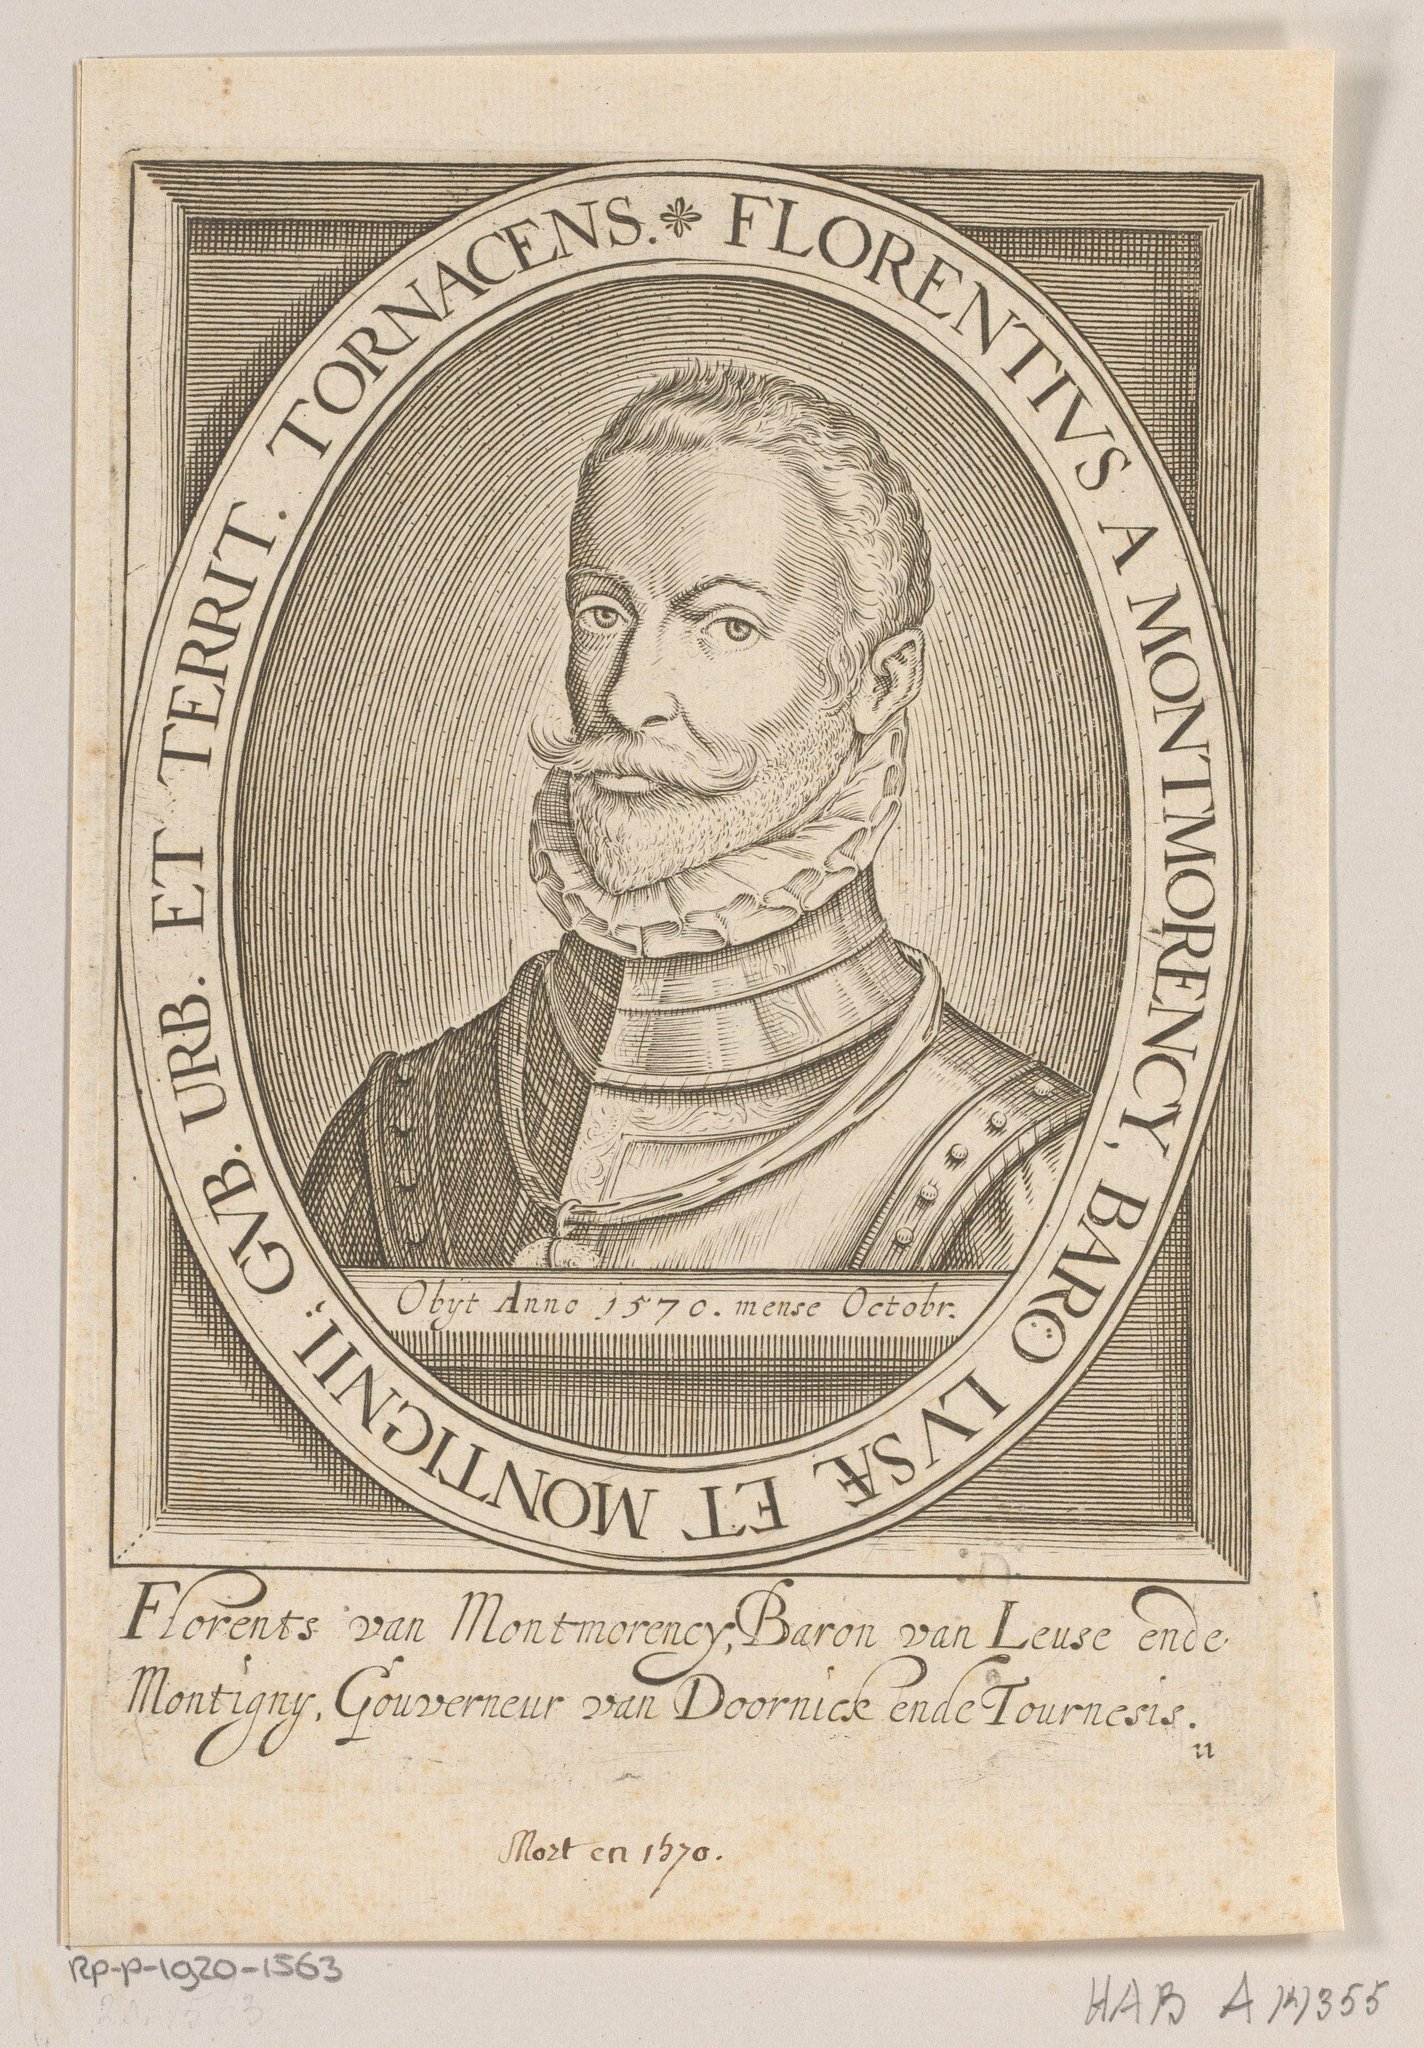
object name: book illustration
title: Portret van Floris van Montmorency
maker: Anonymous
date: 1614-1627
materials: paper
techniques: engraving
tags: historical persons, knighthood order of the golden fleece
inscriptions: collector's mark: Lugt 2228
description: Prent is bijna identiek met de prenten uit uitgaves van: Meteren, Emanuel van. Eigentlich und volkomene historische Beschreibung des Niderlendischen Kriegs uit 1614 [zonder nummer 11] en 1627 [zonder randwerk].